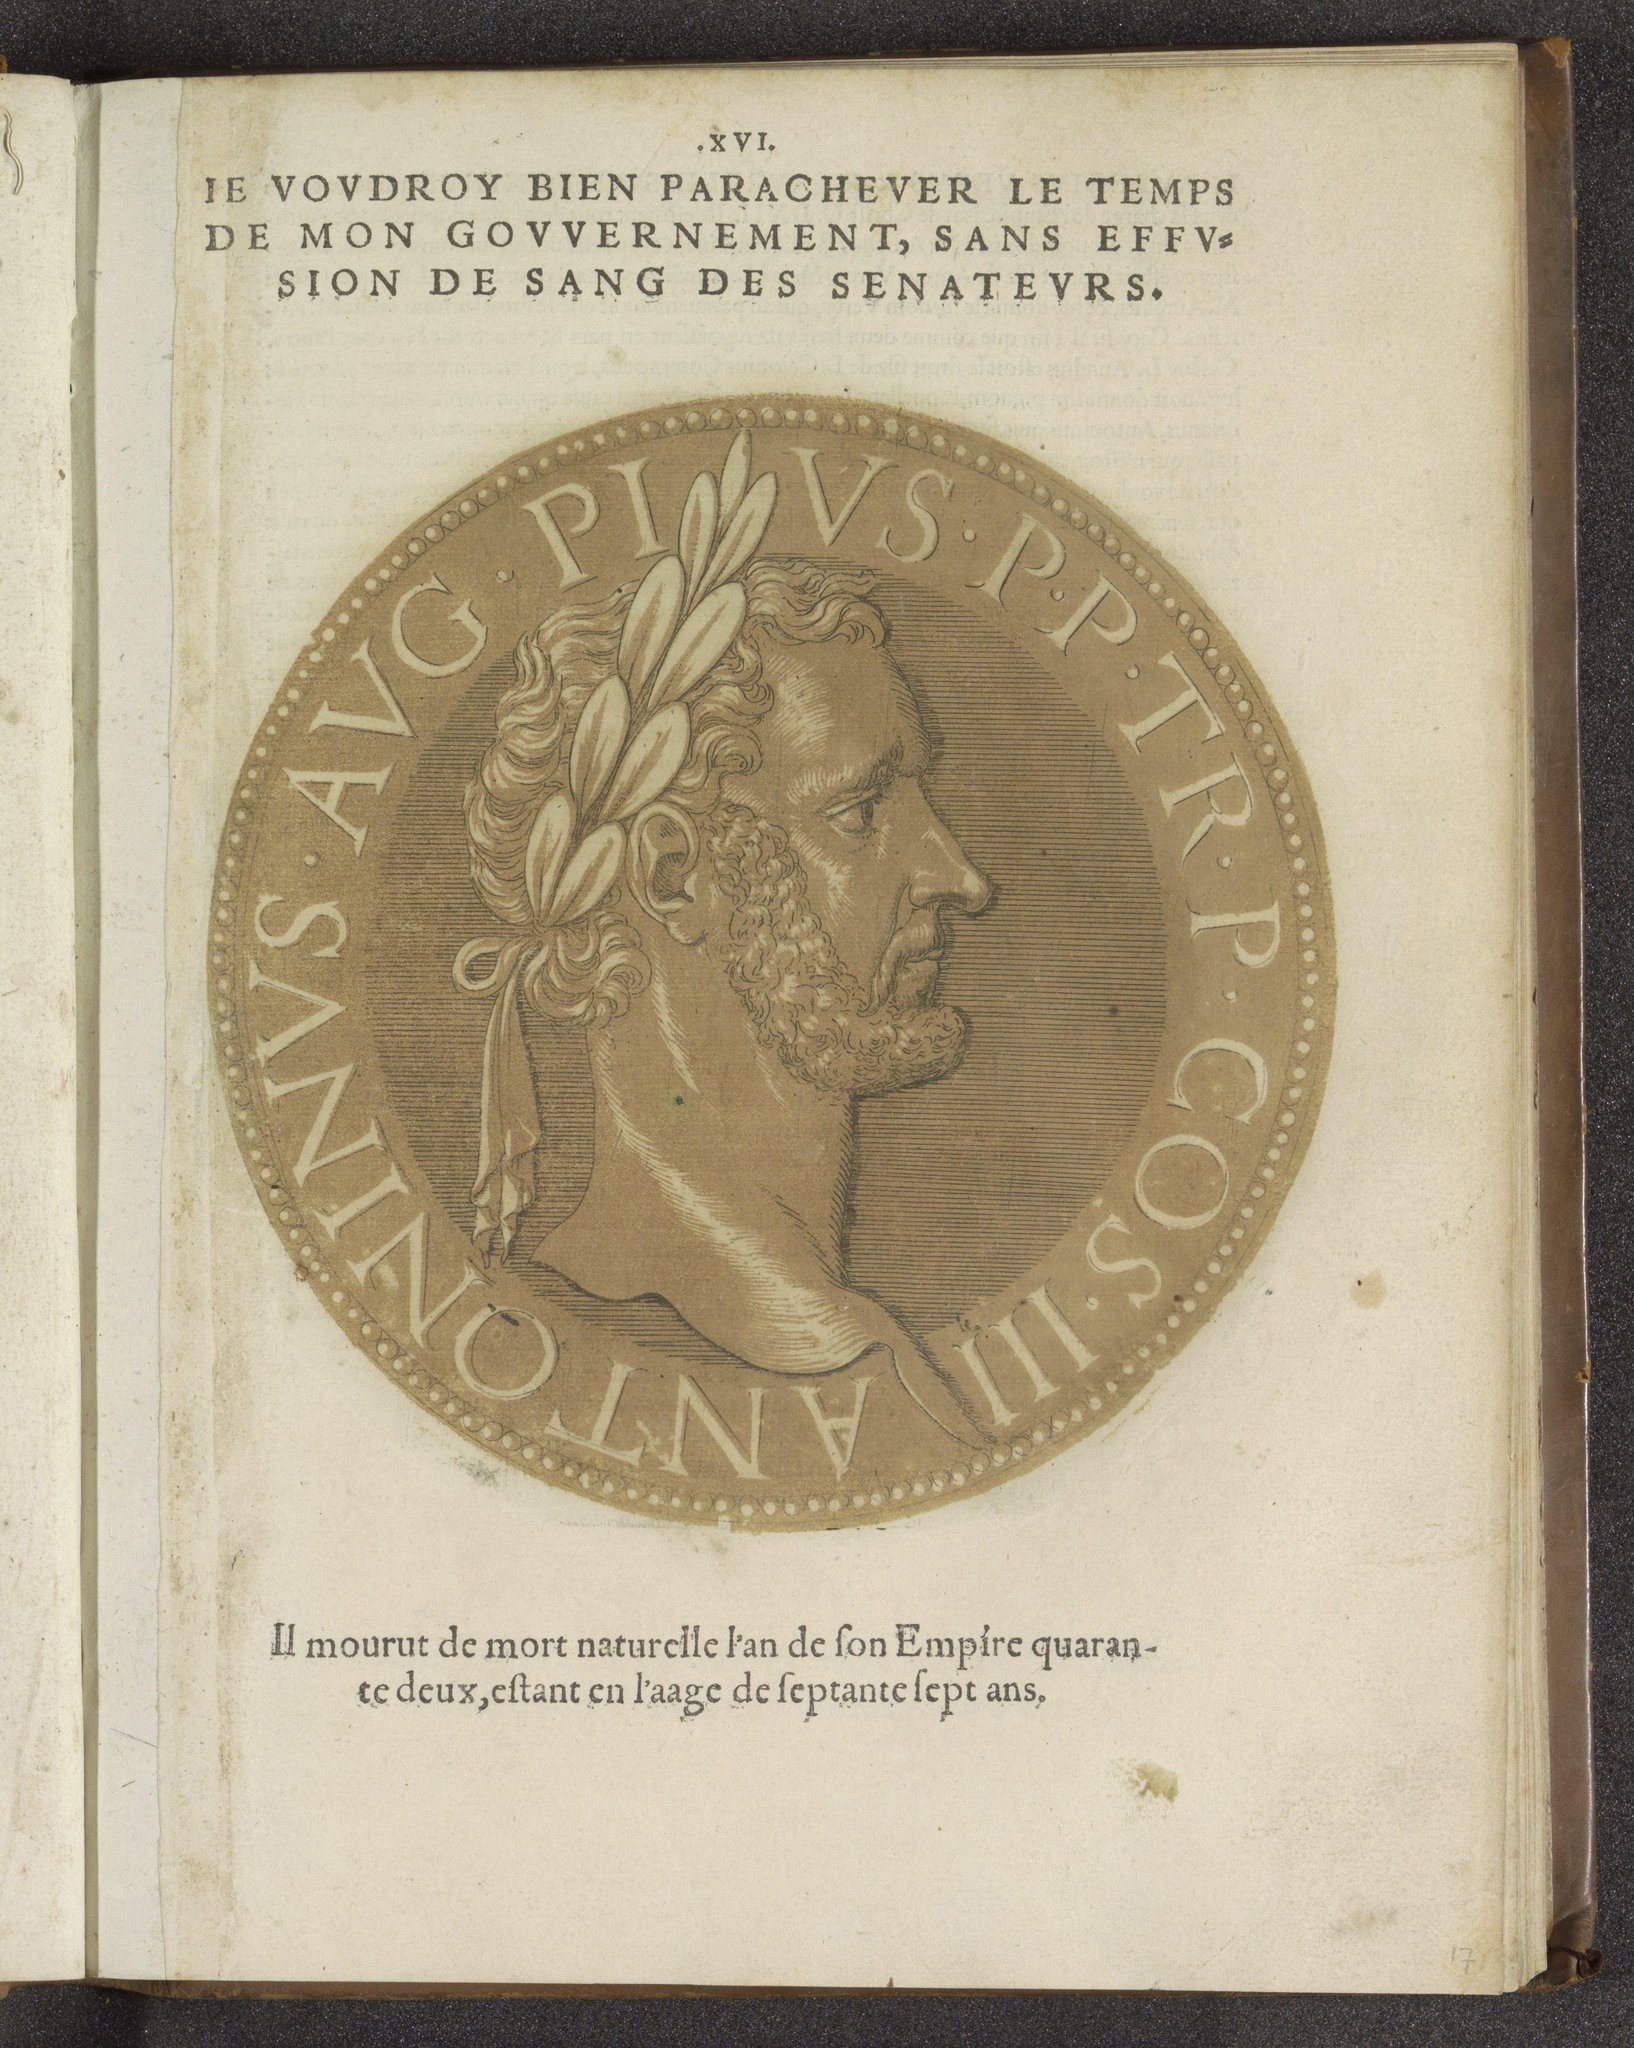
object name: print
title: Les images presque de tous les empereurs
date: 1557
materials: paper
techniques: woodcut, etching, letterpress printing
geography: antwerp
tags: emperor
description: Portret van keizer Antoninus Pius, op een munt met randschrift. De prent maakt deel uit van een boek over de keizers vanaf Julius Caesar tot en met Karel V en zijn broer Ferdinand.